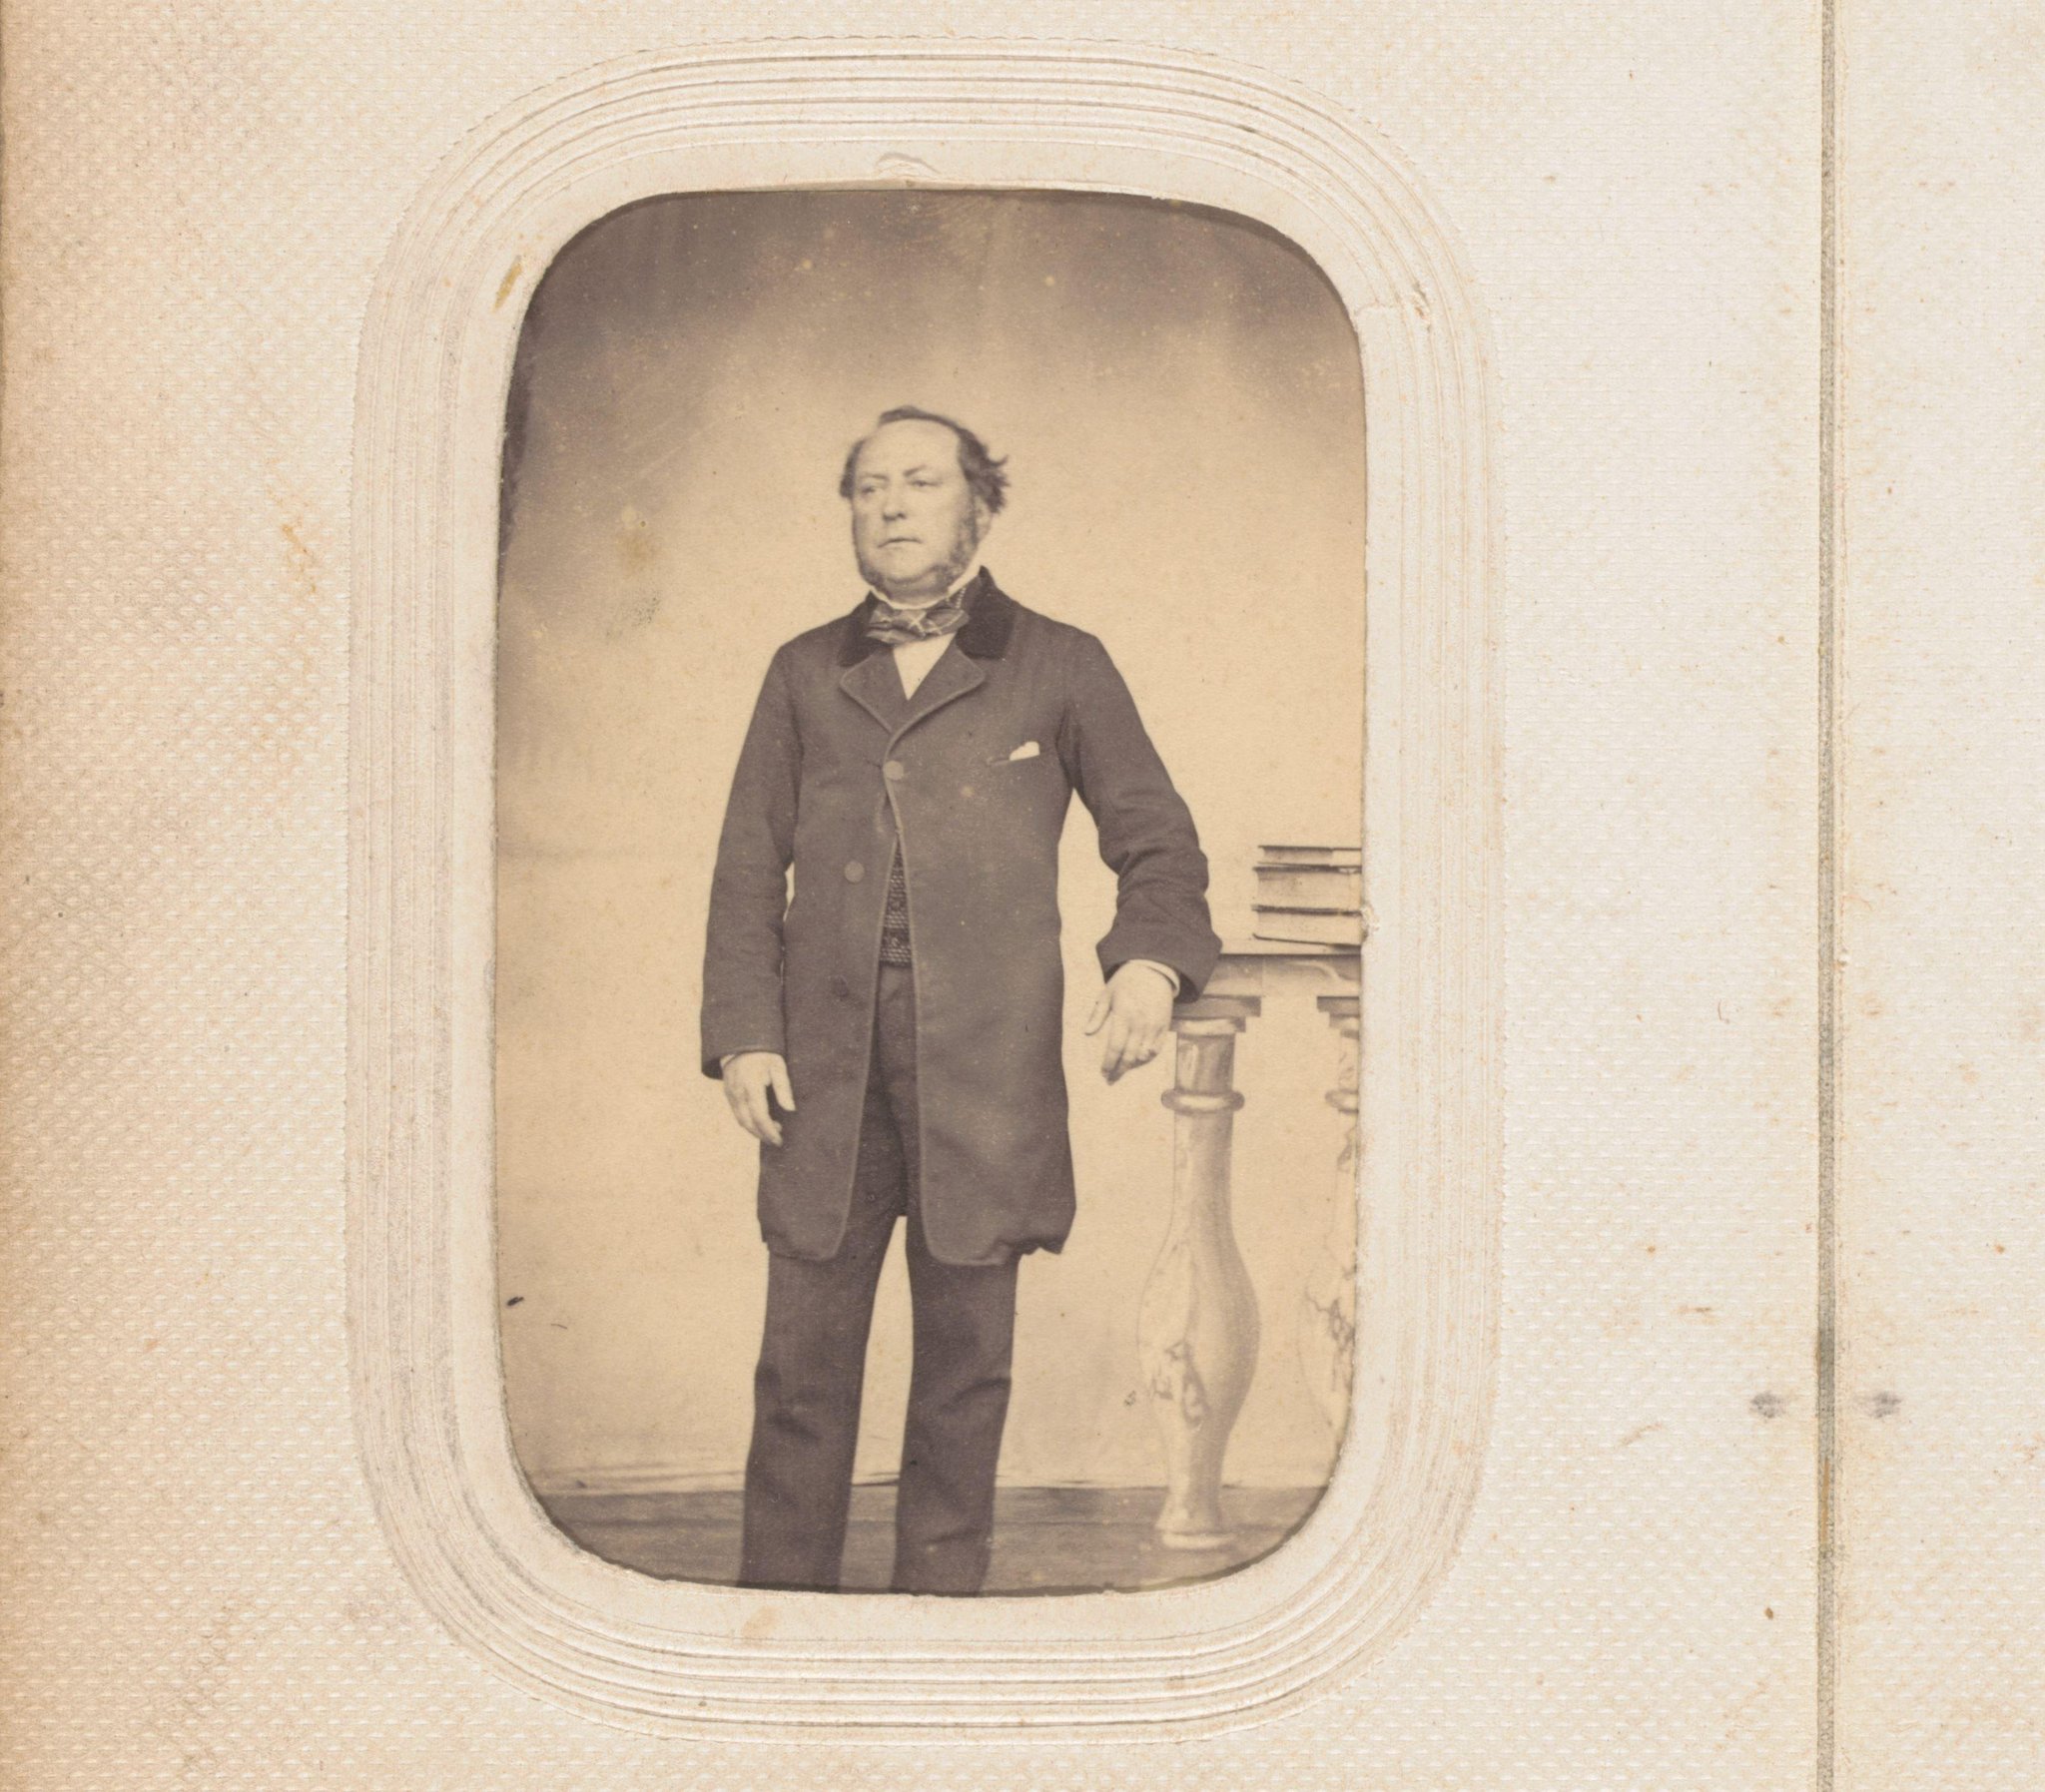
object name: album leaf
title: Portret van een staande man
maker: Anonymous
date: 1860-1870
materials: cardboard, photographic support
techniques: albumen print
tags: adult man, historical persons